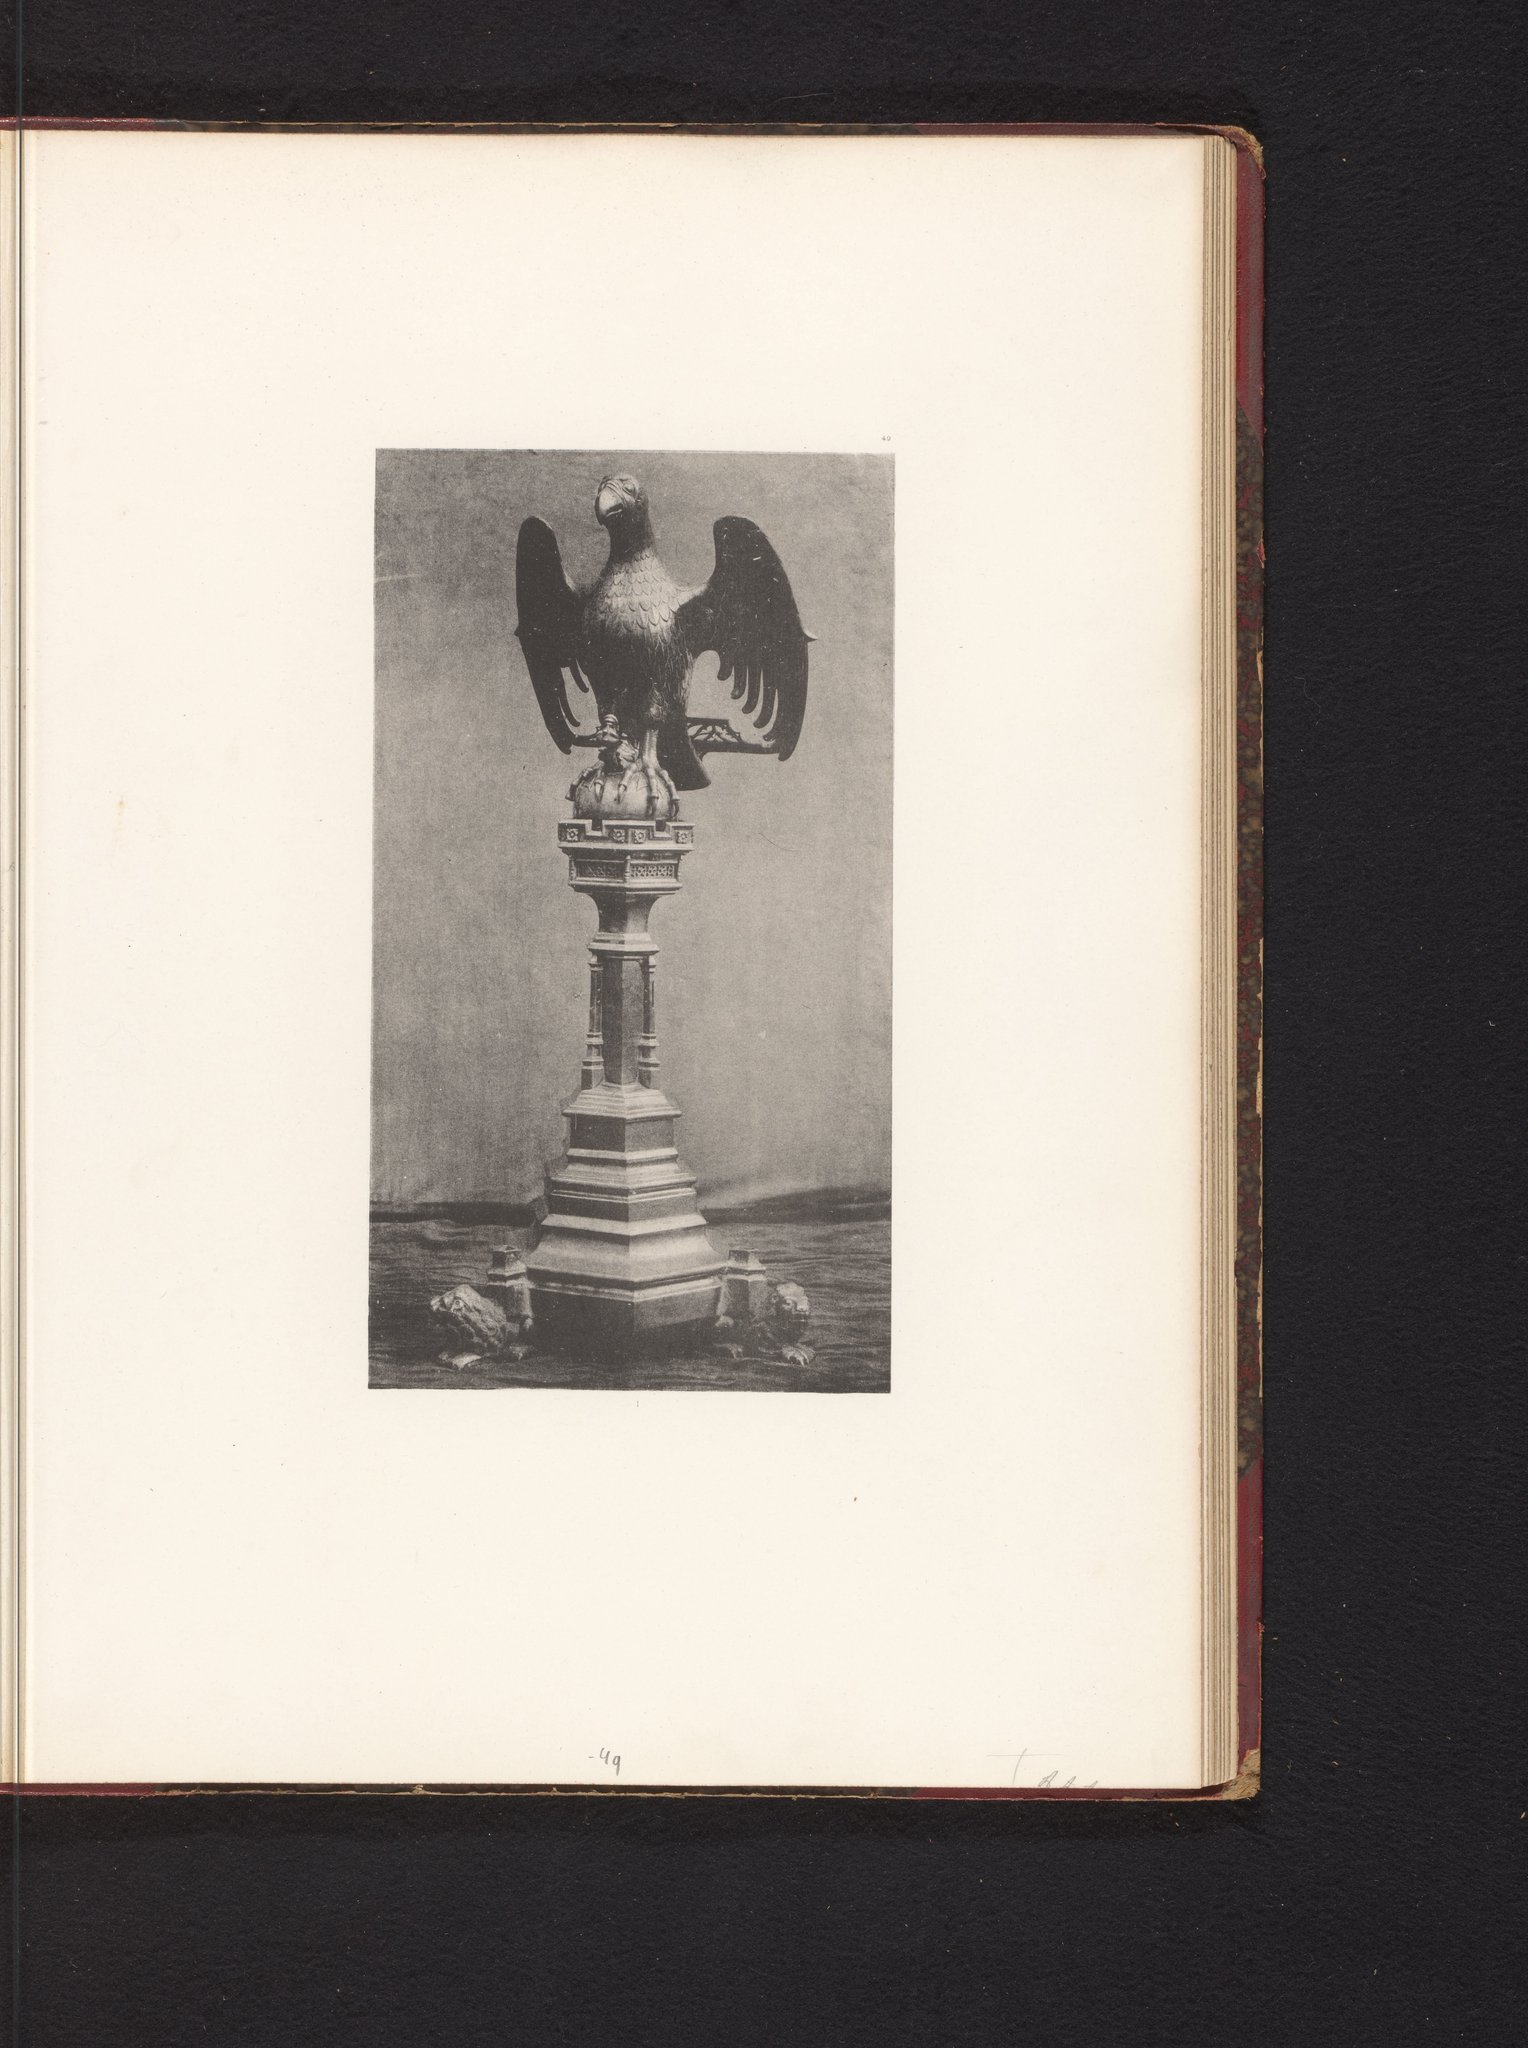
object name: page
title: Sculptuur van een adelaar op een voetstuk uit de Sint-Martinusbasiliek in Halle, opgesteld op een tentoonstelling over religieuze objecten uit de middeleeuwen en renaissance in 1864 in Mechelen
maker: joseph maes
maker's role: fotograaf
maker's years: 1838-1908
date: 1864-1866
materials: paper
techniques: photolithography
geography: mechelen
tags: predatory birds: eagle, piece of sculpture, reproduction of a piece of sculpture (+ metals ~ arts), mechelen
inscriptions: number: ‘-49’, number: ‘I [...]’, number: ‘1’